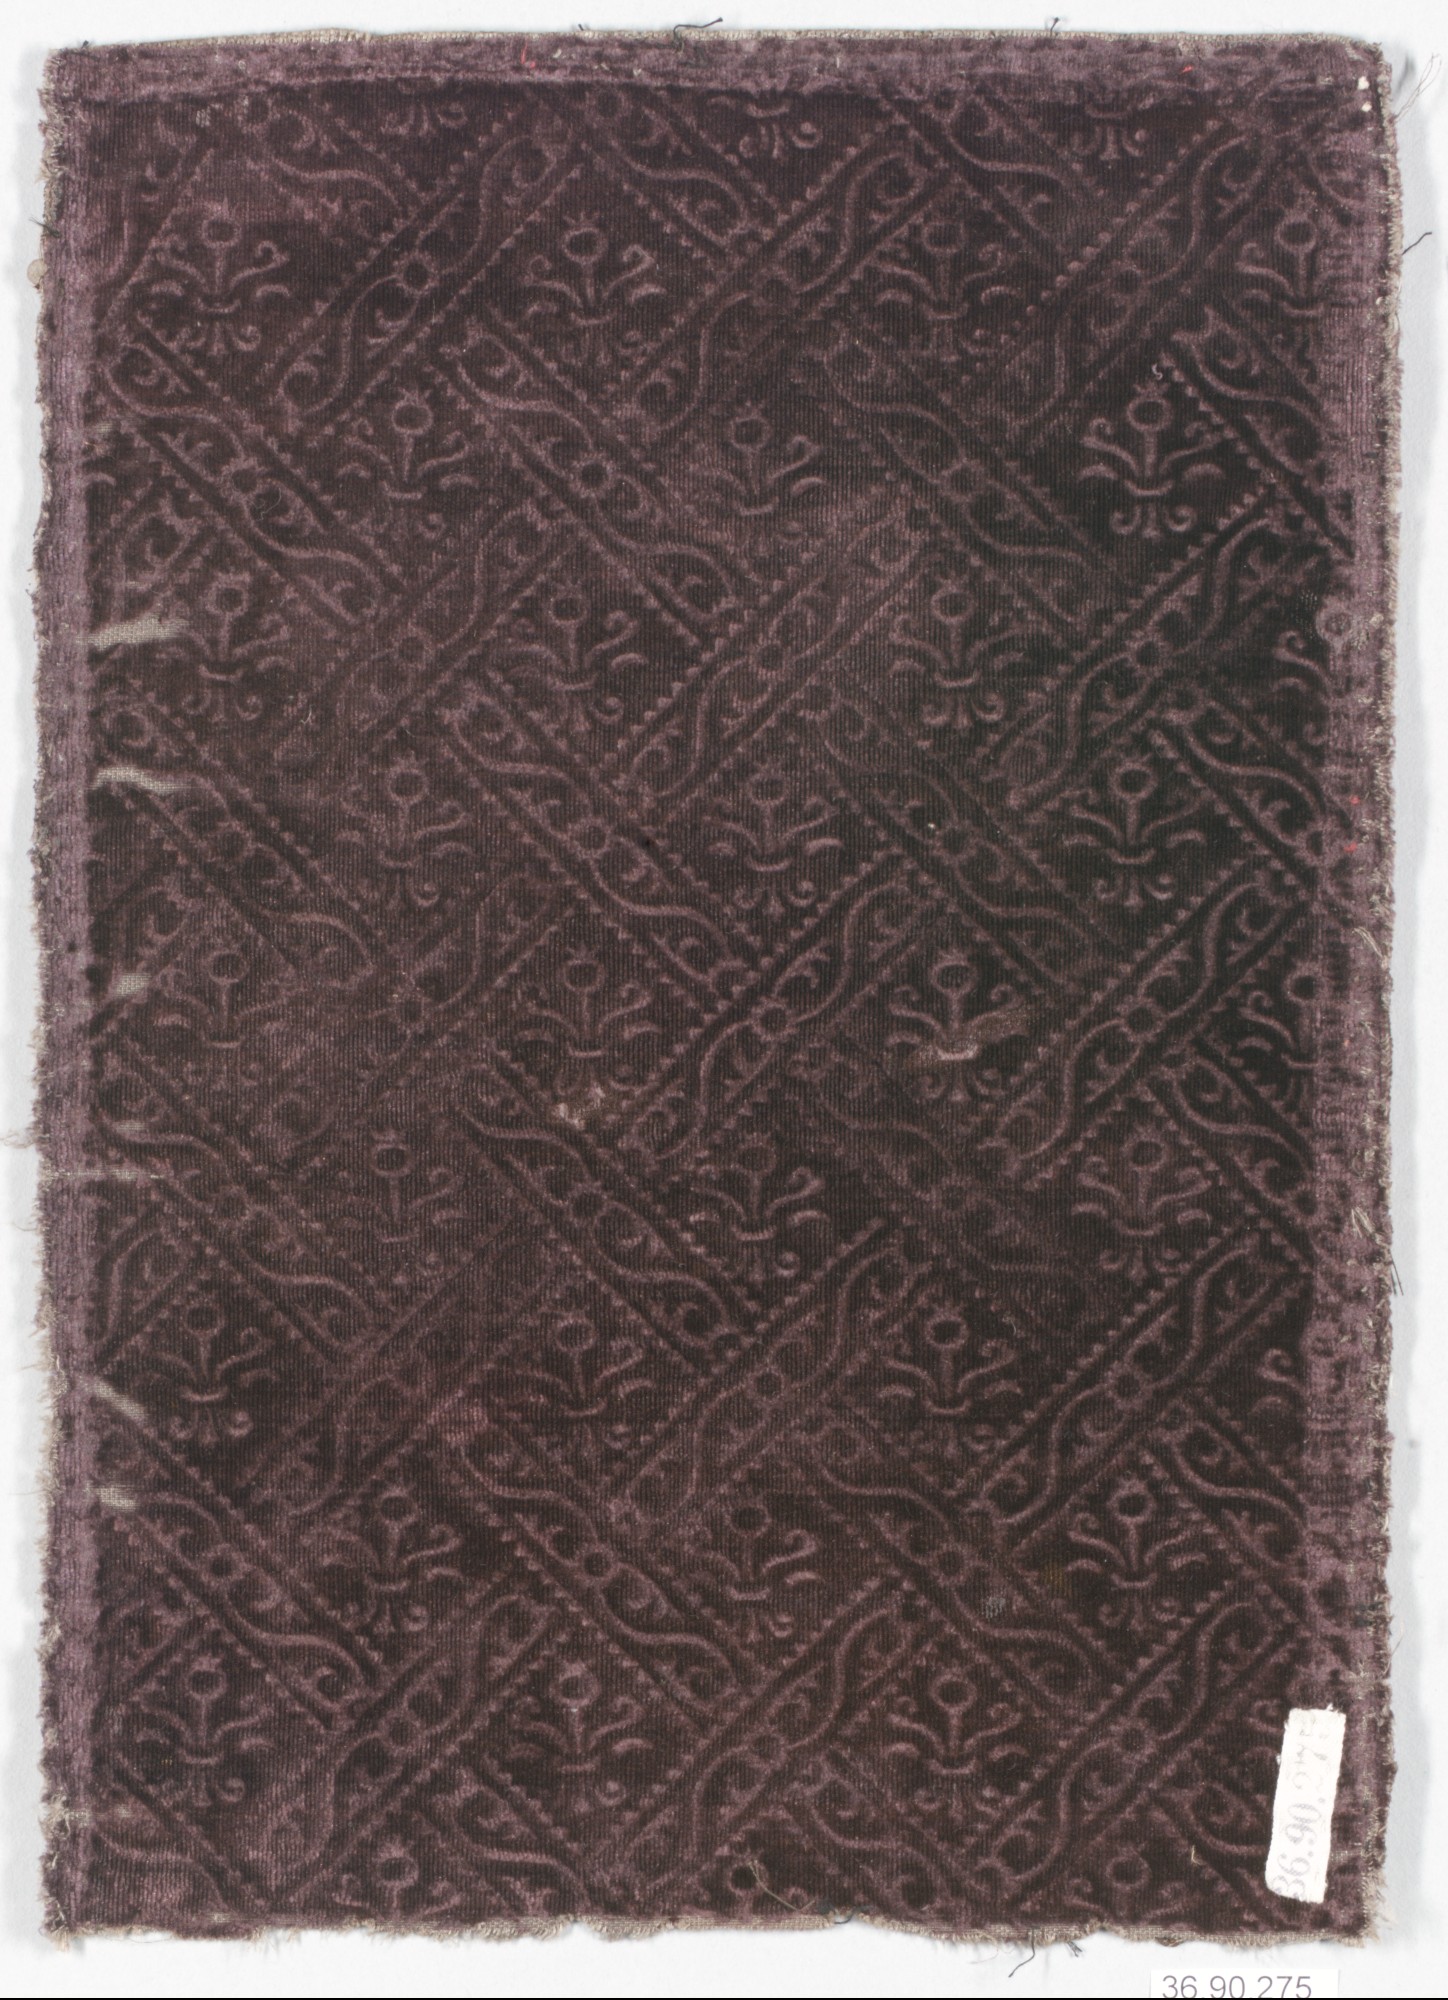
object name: piece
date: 1501-1700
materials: silk